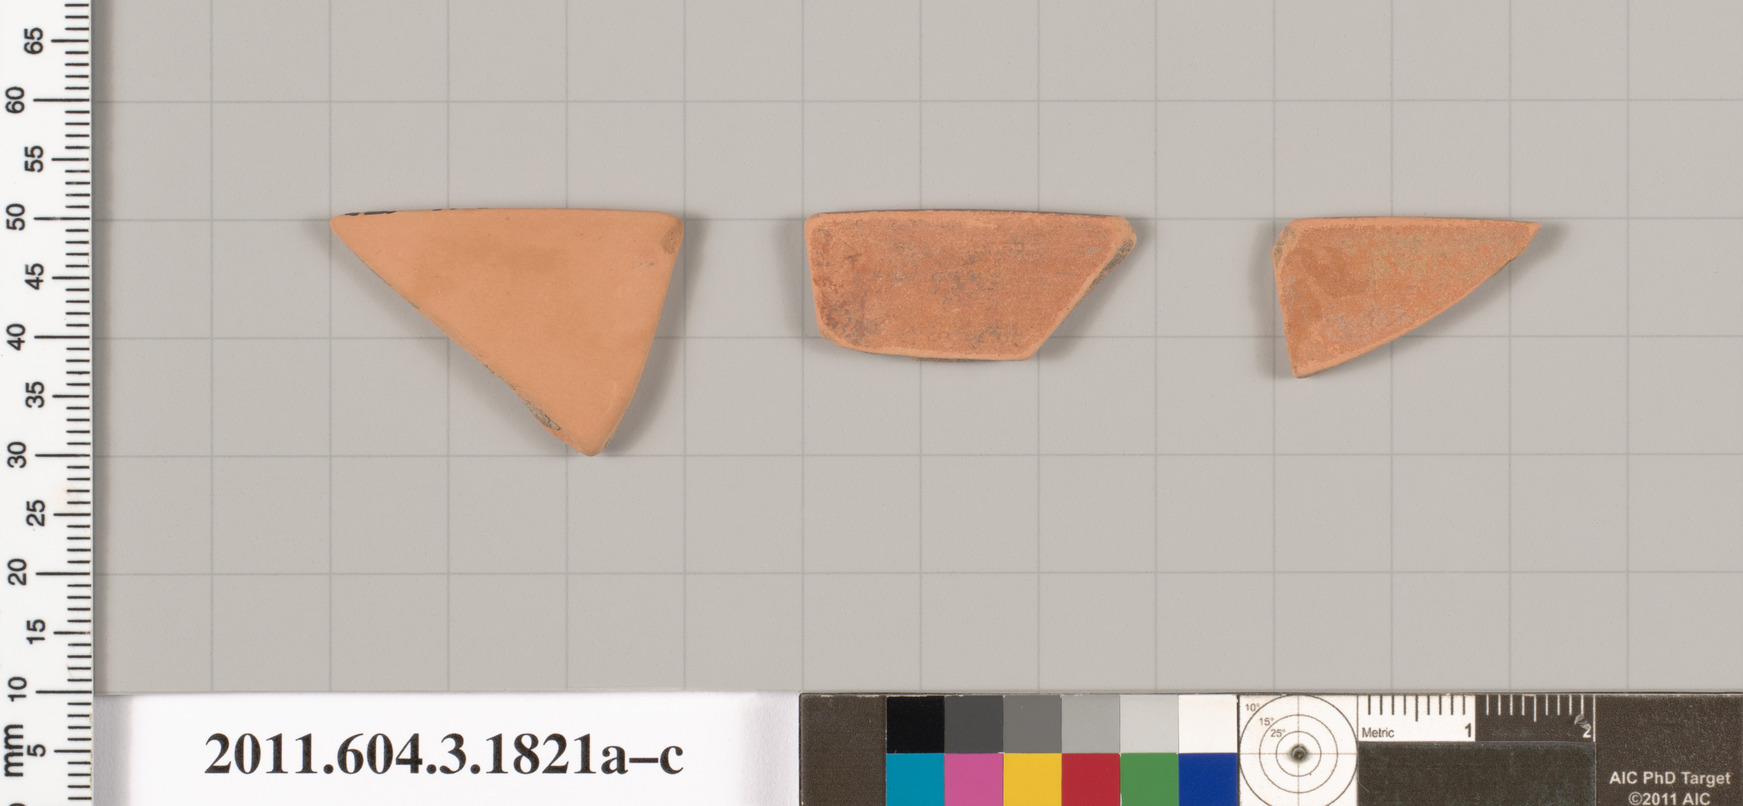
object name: kylix fragment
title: Terracotta rim fragments of kylikes: Lip cup (drinking cup)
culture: greek, attic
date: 560-525 BCE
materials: terracotta